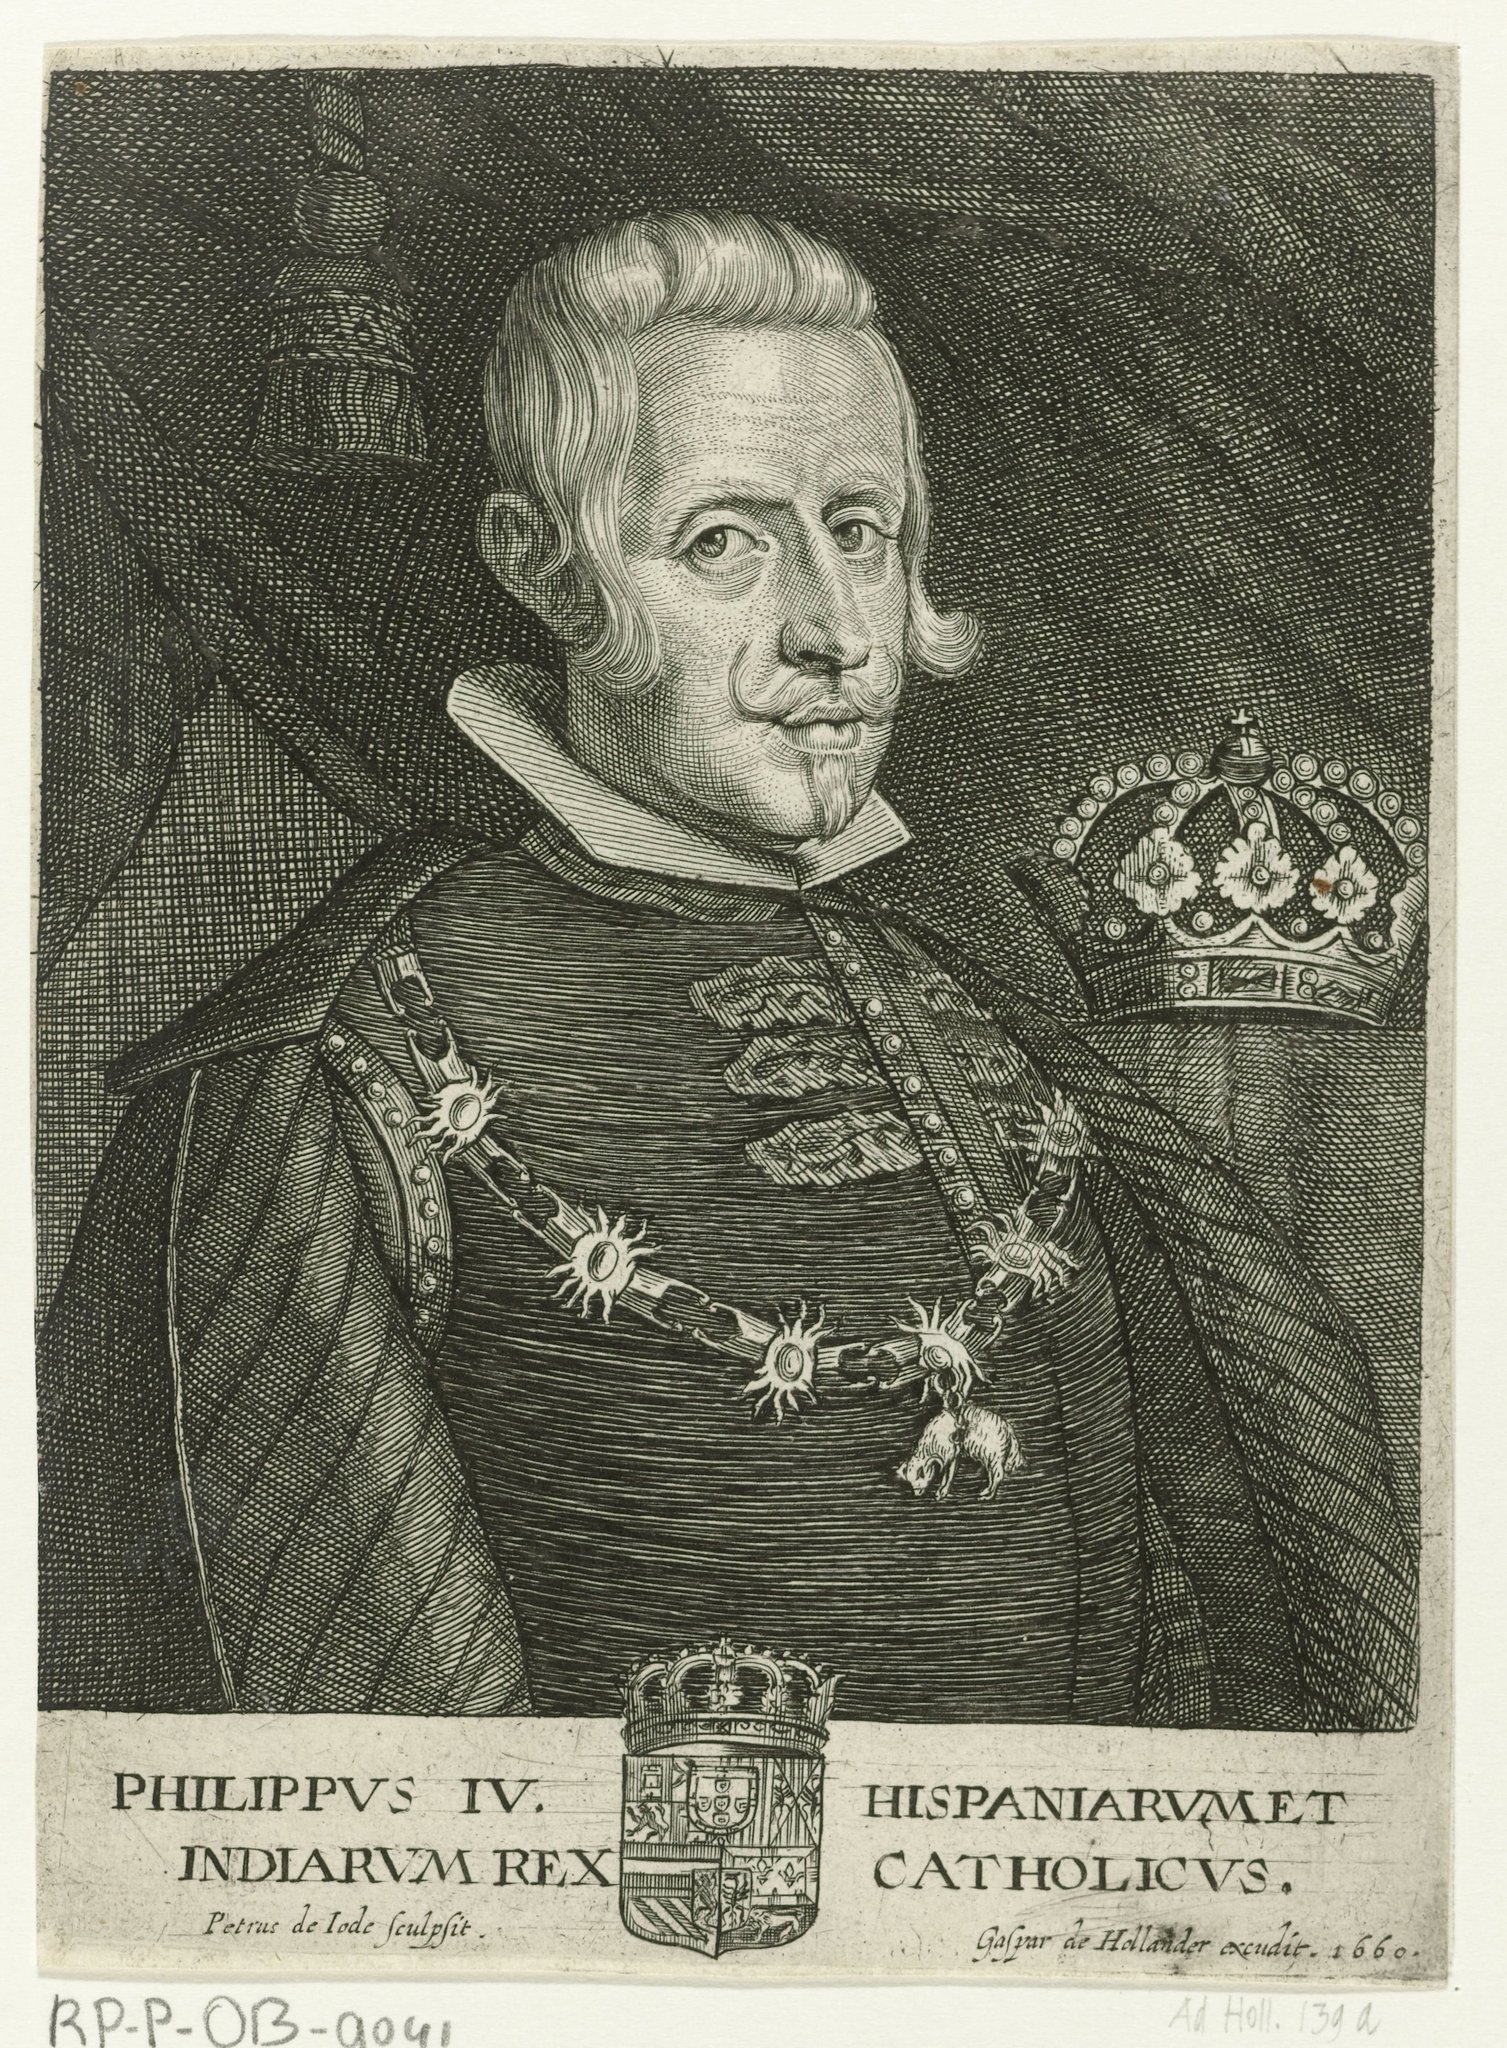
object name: print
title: Busteportret van Filips IV, koning van Spanje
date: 1660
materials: paper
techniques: engraving, etching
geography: antwerp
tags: filips iv (koning van spanje), crown (symbol of sovereignty), knighthood order of the golden fleece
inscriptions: collector's mark: Lugt 2228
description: Busteportret van Filips IV, koning van Spanje. Hij draagt een keten met de Orde van het Gulden Vlies. Op de achtergrond een kroon. In de marge het wapenschild van de geportretteerde en een tweeregelig onderschrift in het Latijn.